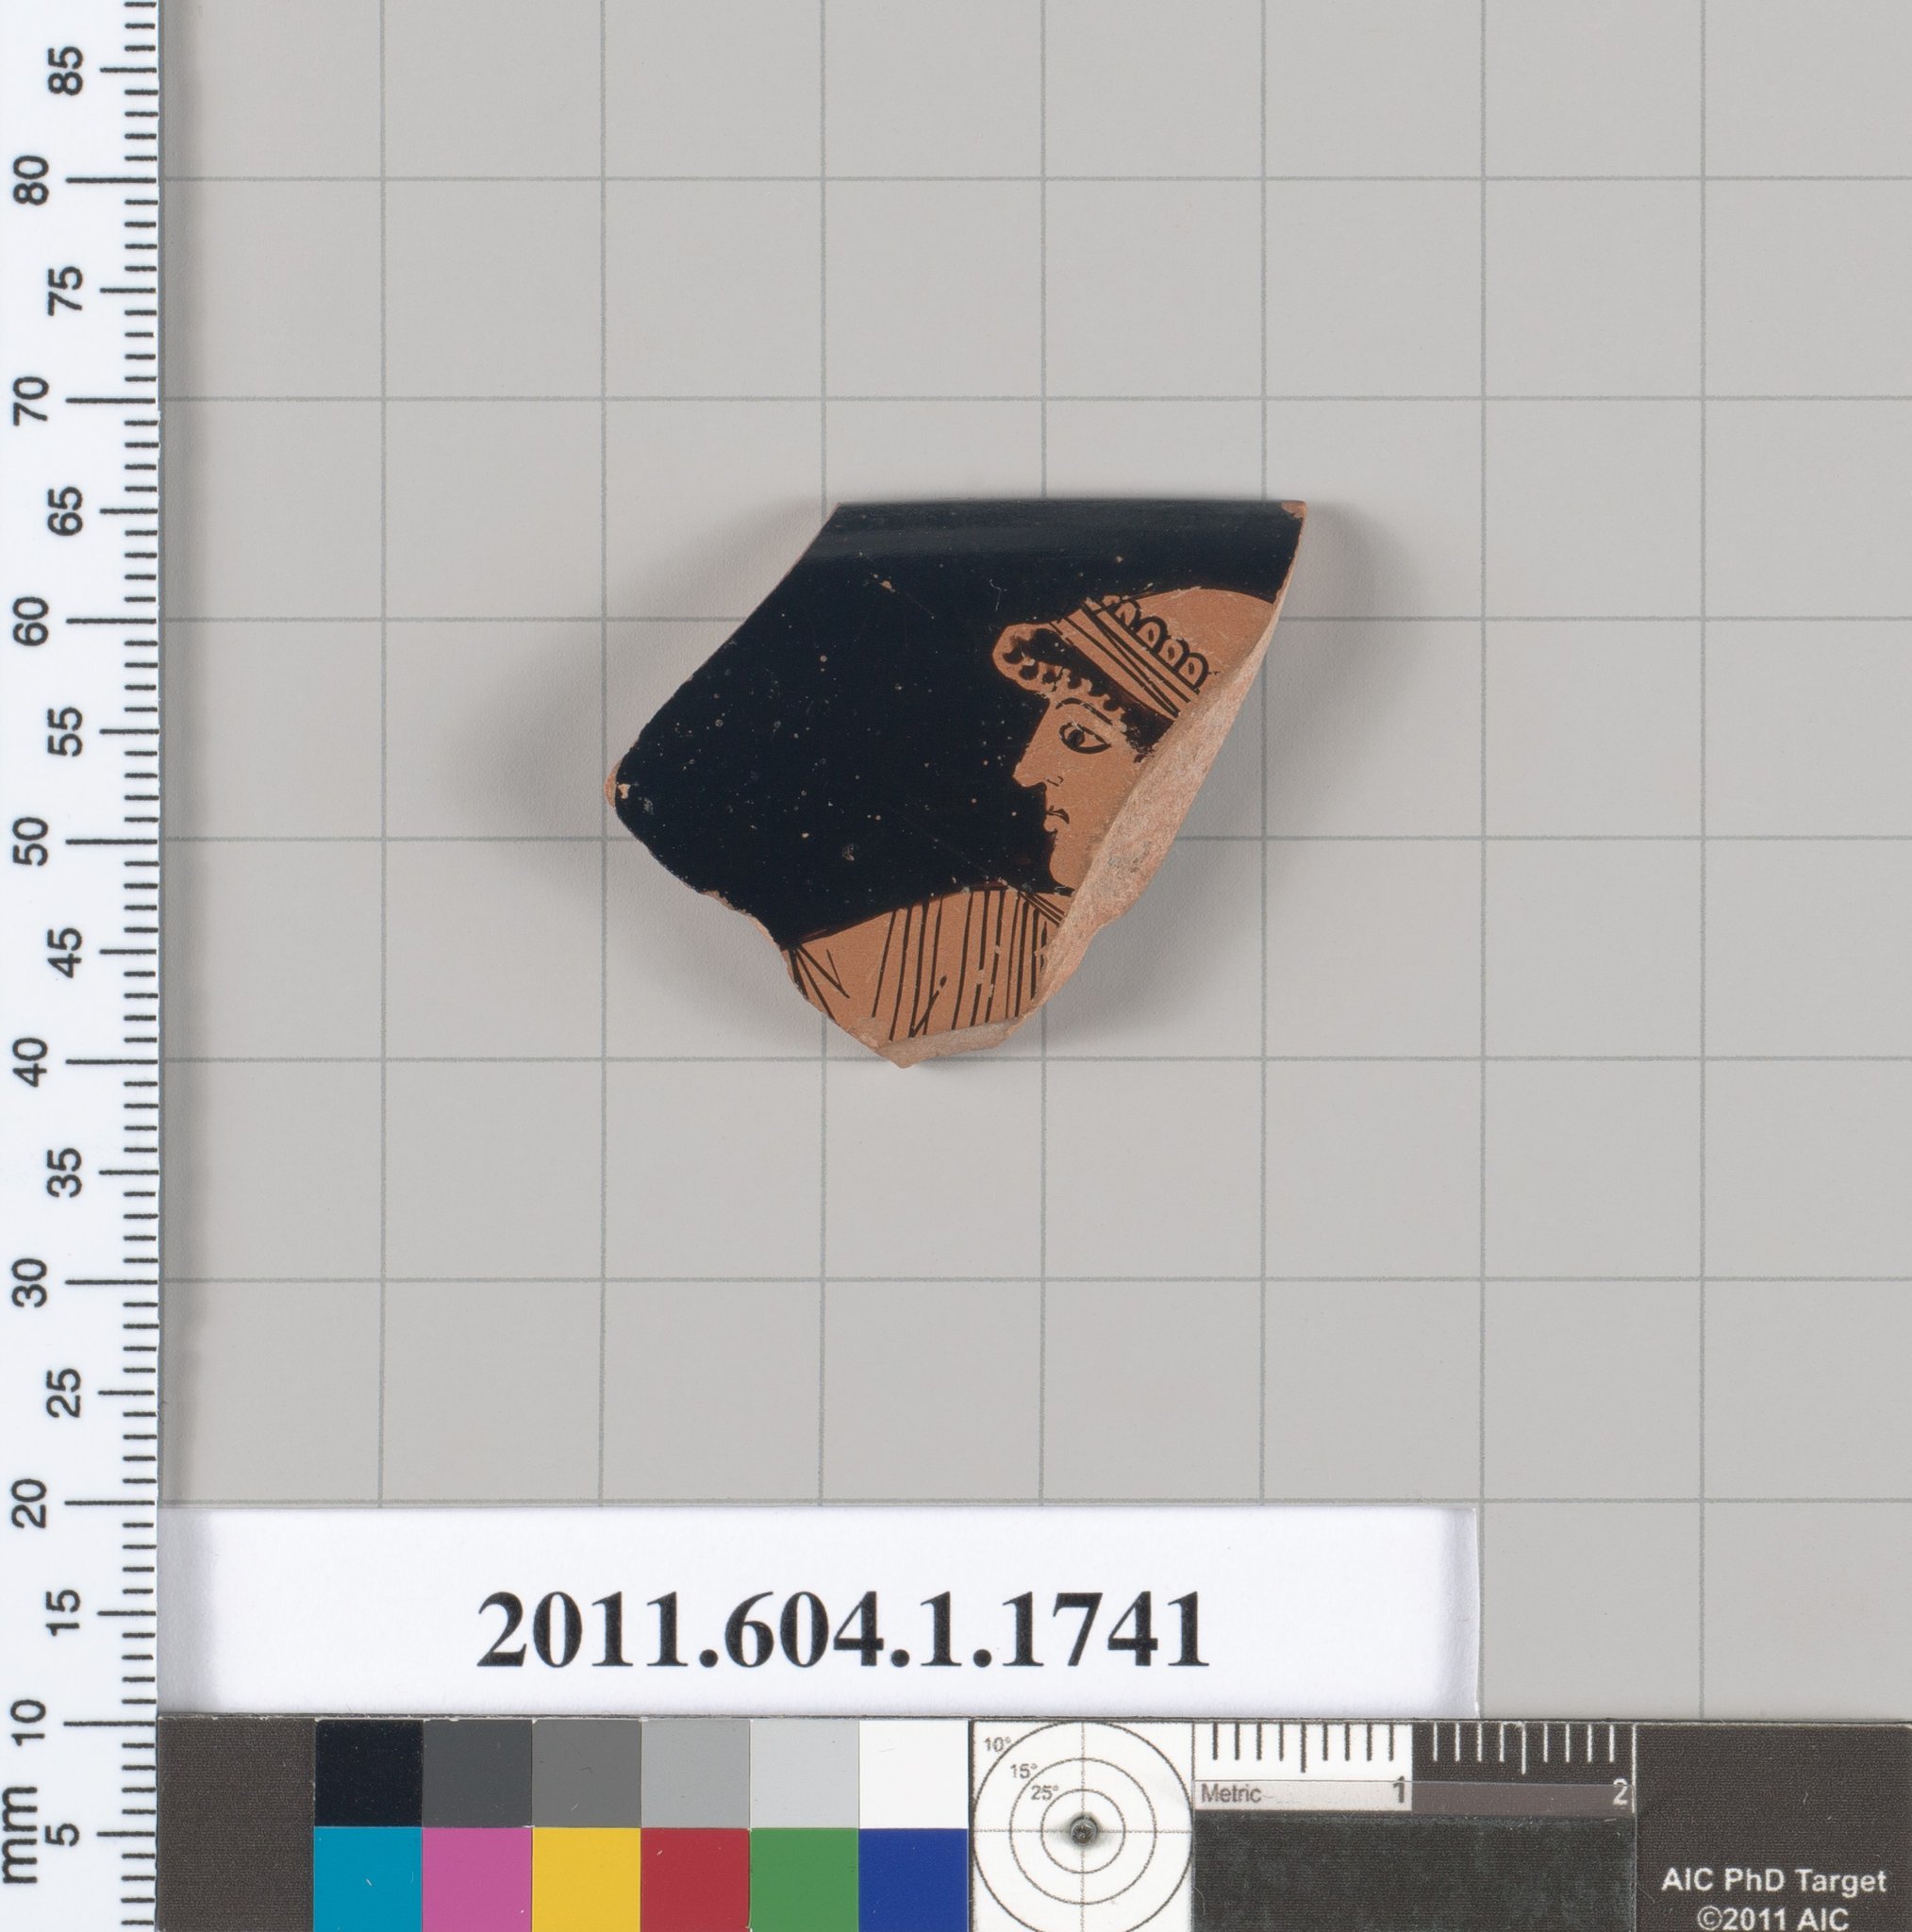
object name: kylix fragment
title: Terracotta rim fragment of a kylix (drinking cup)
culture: greek, attic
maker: briseis painter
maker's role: artist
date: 480-470 BCE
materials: terracotta